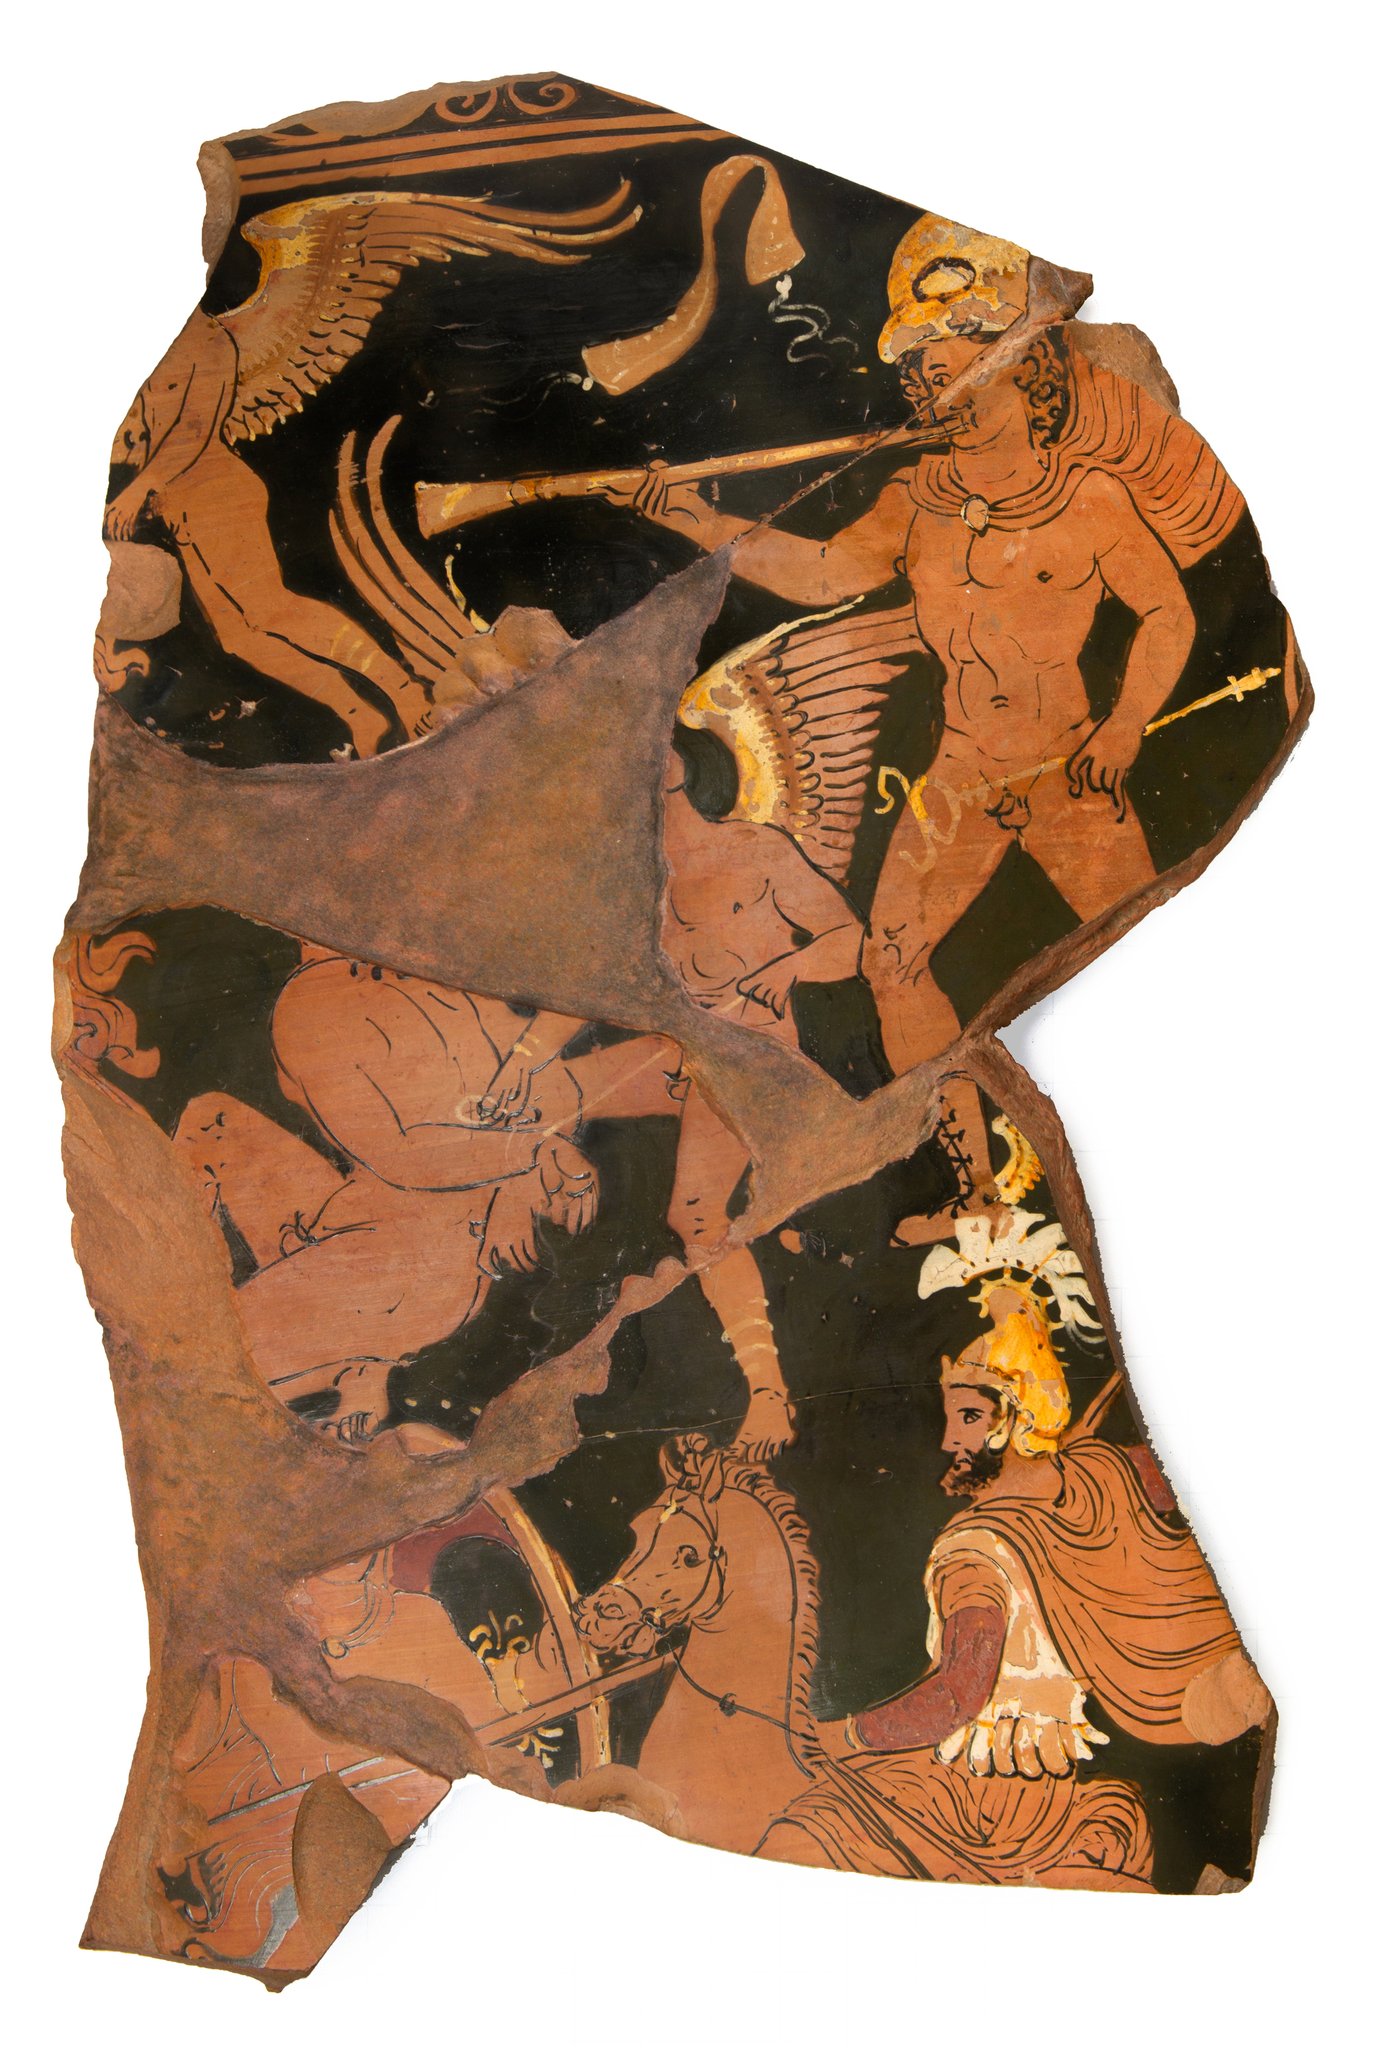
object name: volute krater fragment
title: Fragment of a terracotta volute-krater (bowl for mixing wine and water); joins 19.192.81.5,.10,.19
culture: greek, south italian, apulian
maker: baltimore painter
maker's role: artist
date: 325-301 BCE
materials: terracotta